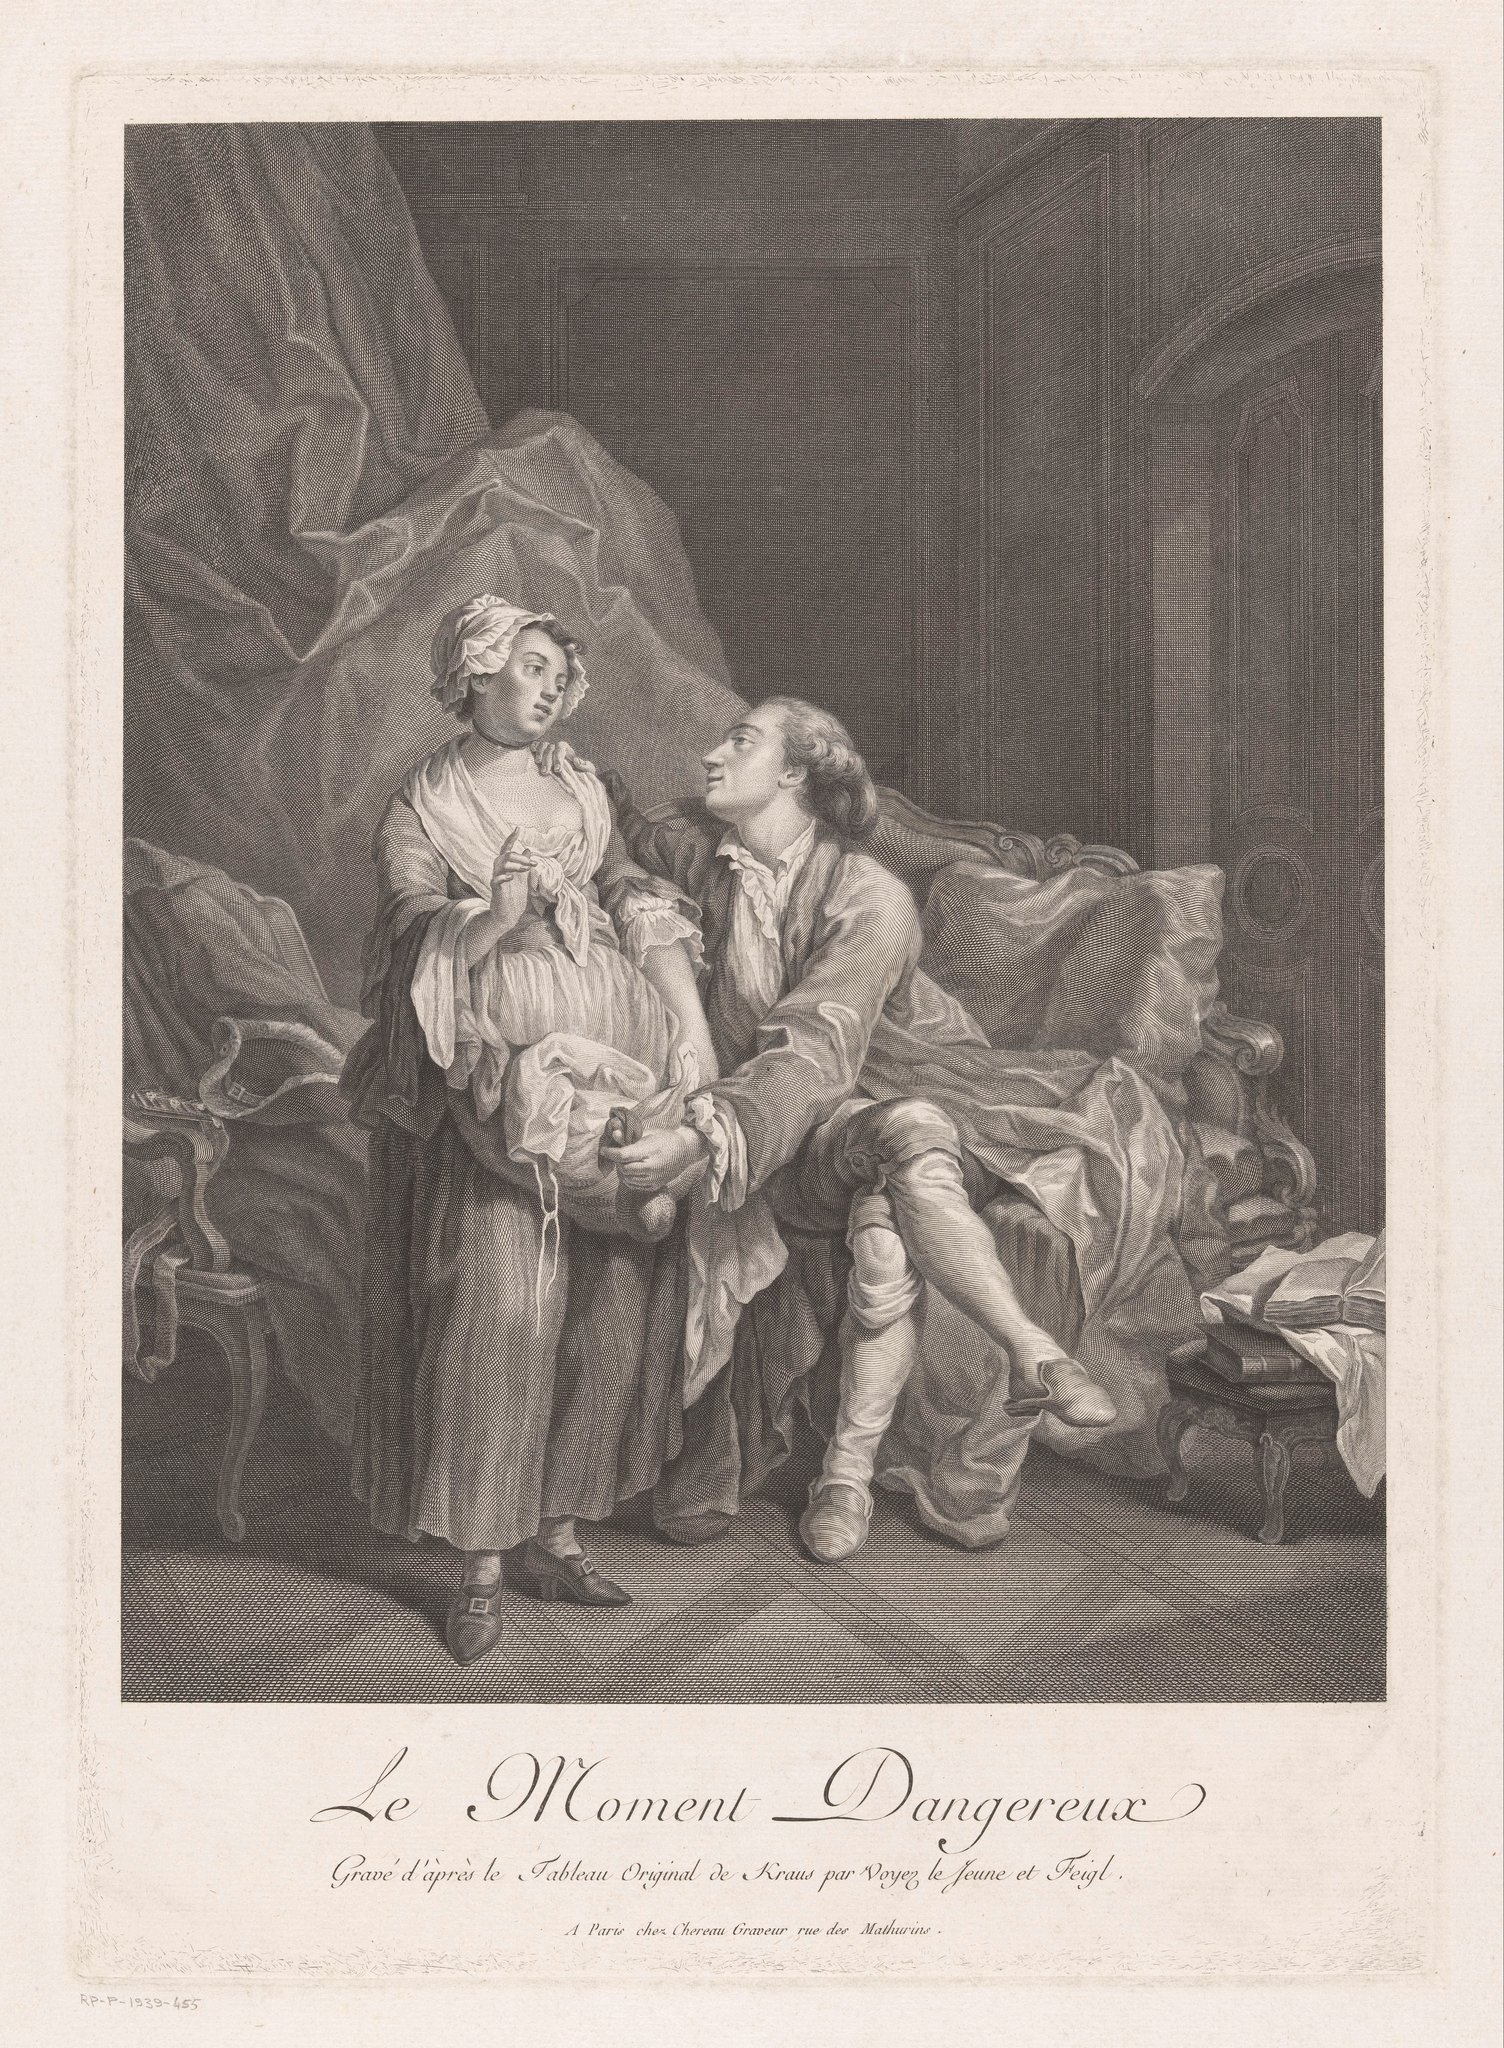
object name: print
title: Le Moment Dangereux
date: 1784-1785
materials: paper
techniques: engraving, etching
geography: paris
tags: interior of the house, maid ~ house personnel, lovers; courting, flirting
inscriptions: collector's mark: Lugt 2166, collector's mark: Lugt 2760